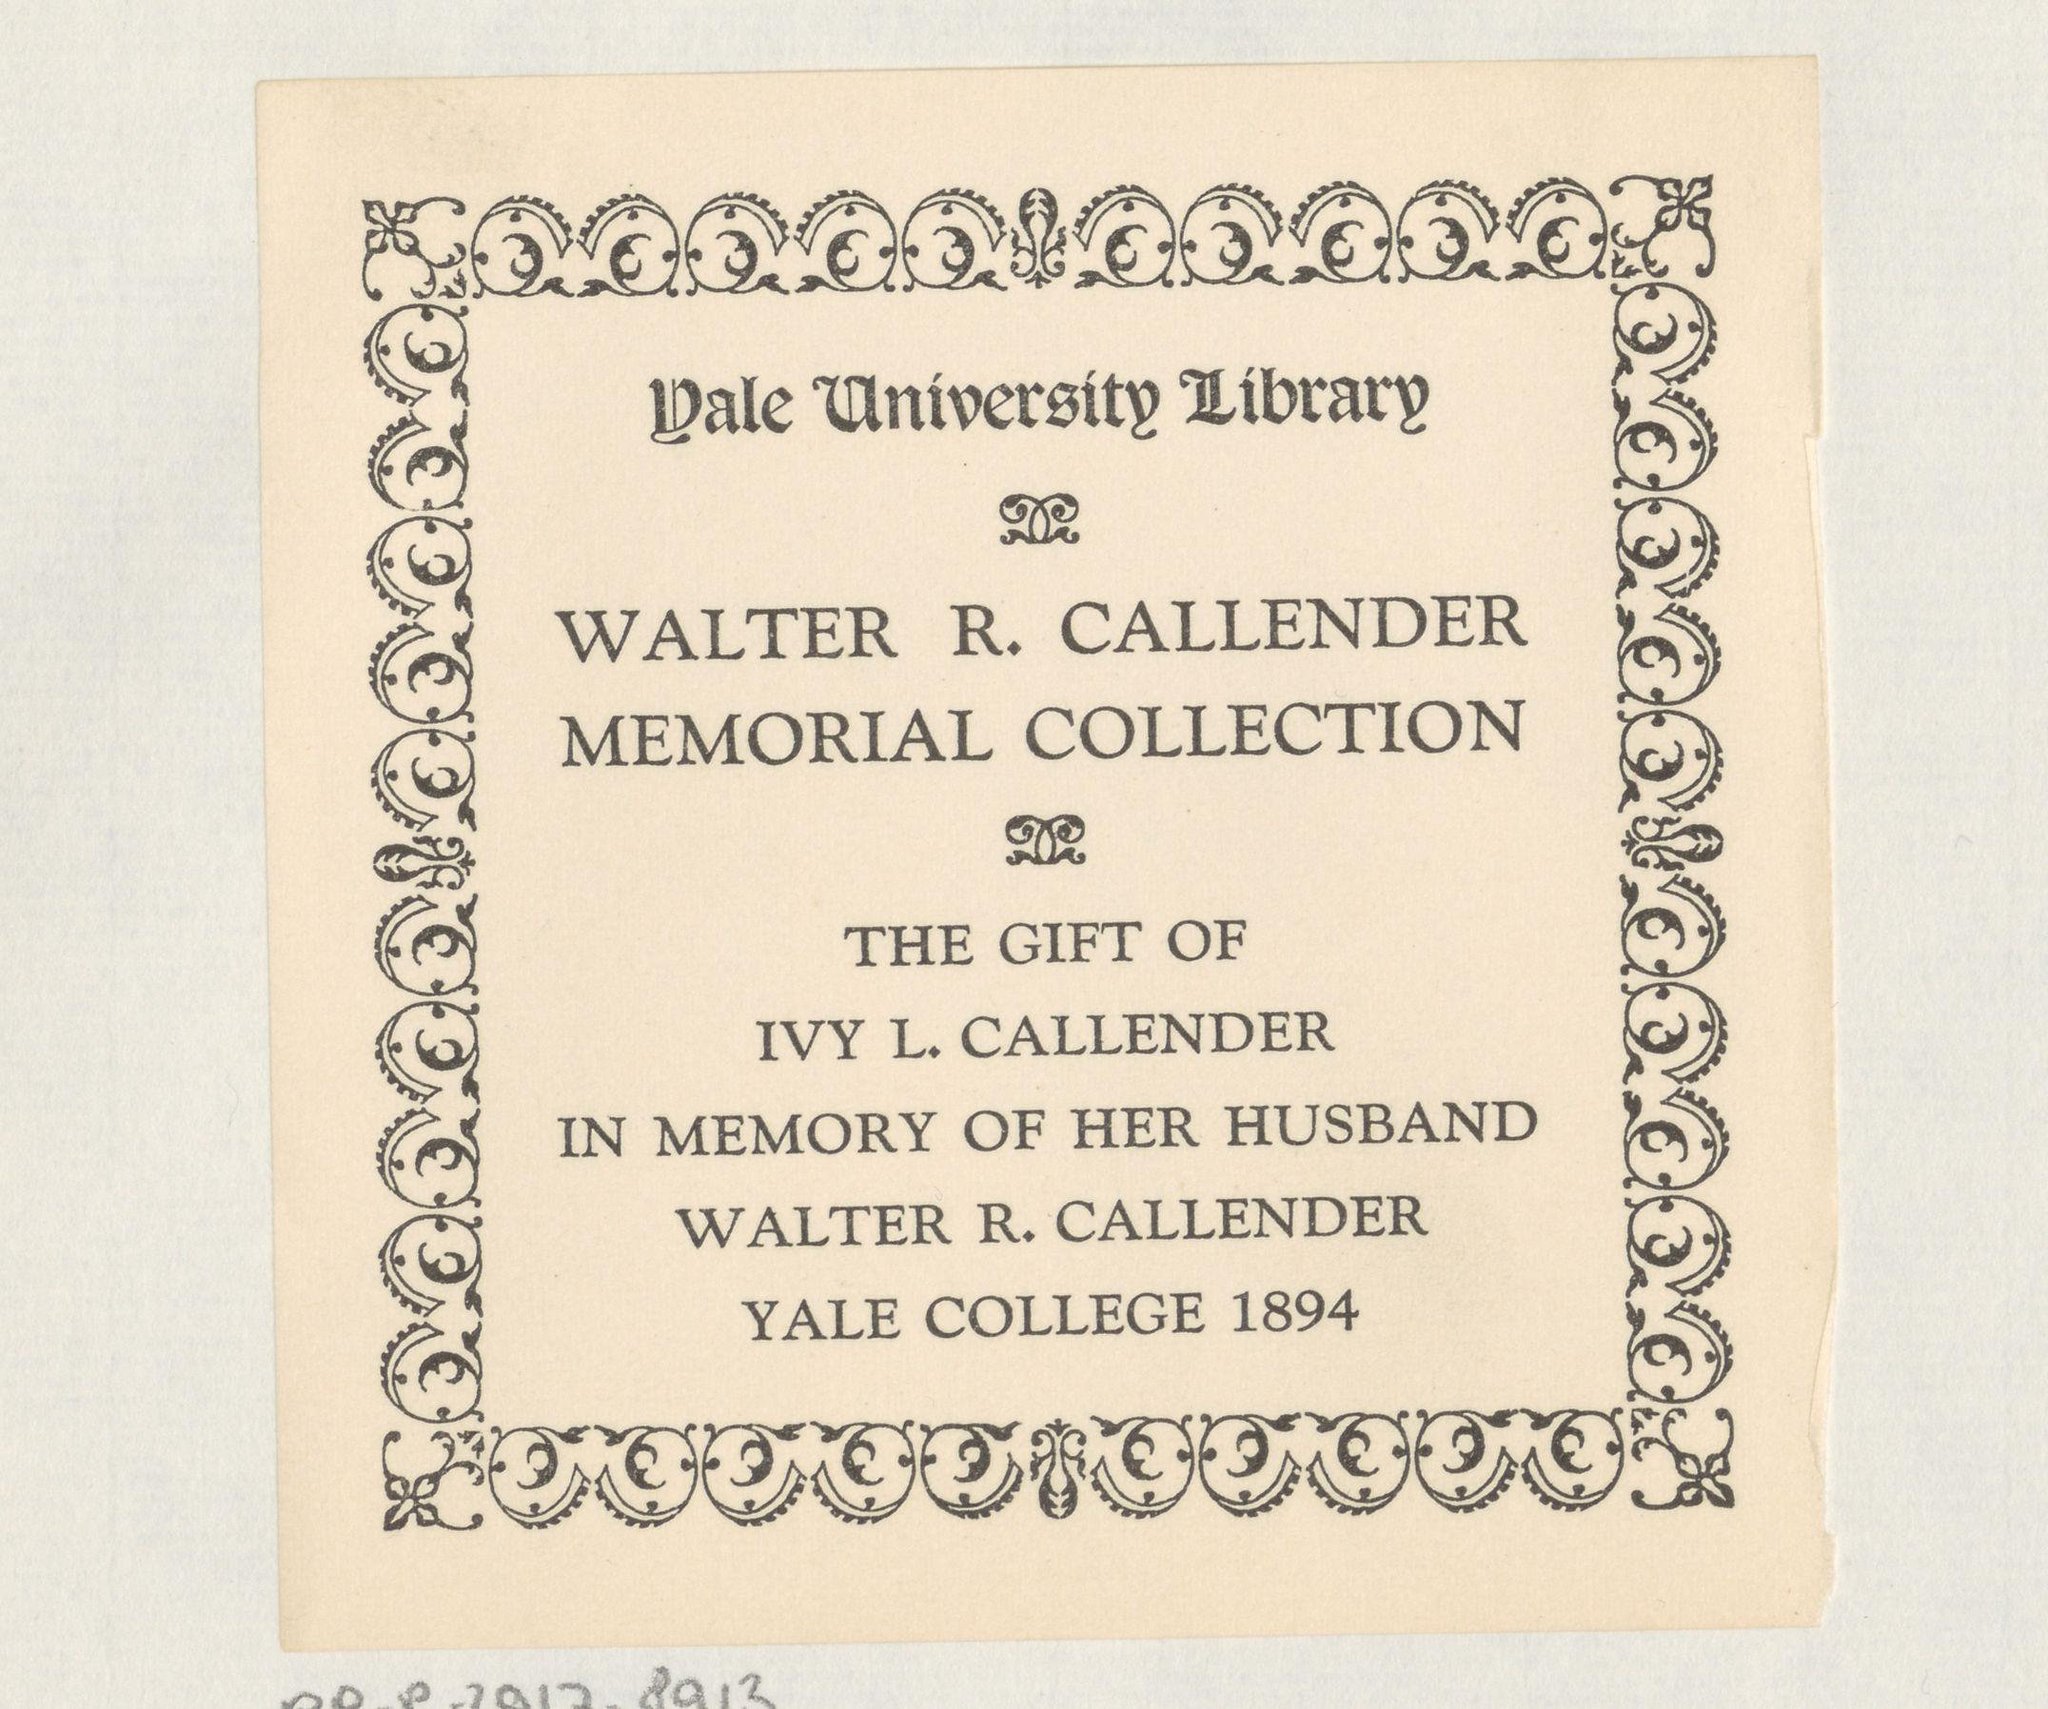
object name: bookplate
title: Ex libris van de Yale University Library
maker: Anonymous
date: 1900-1999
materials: paper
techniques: printing block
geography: north and central america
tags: university